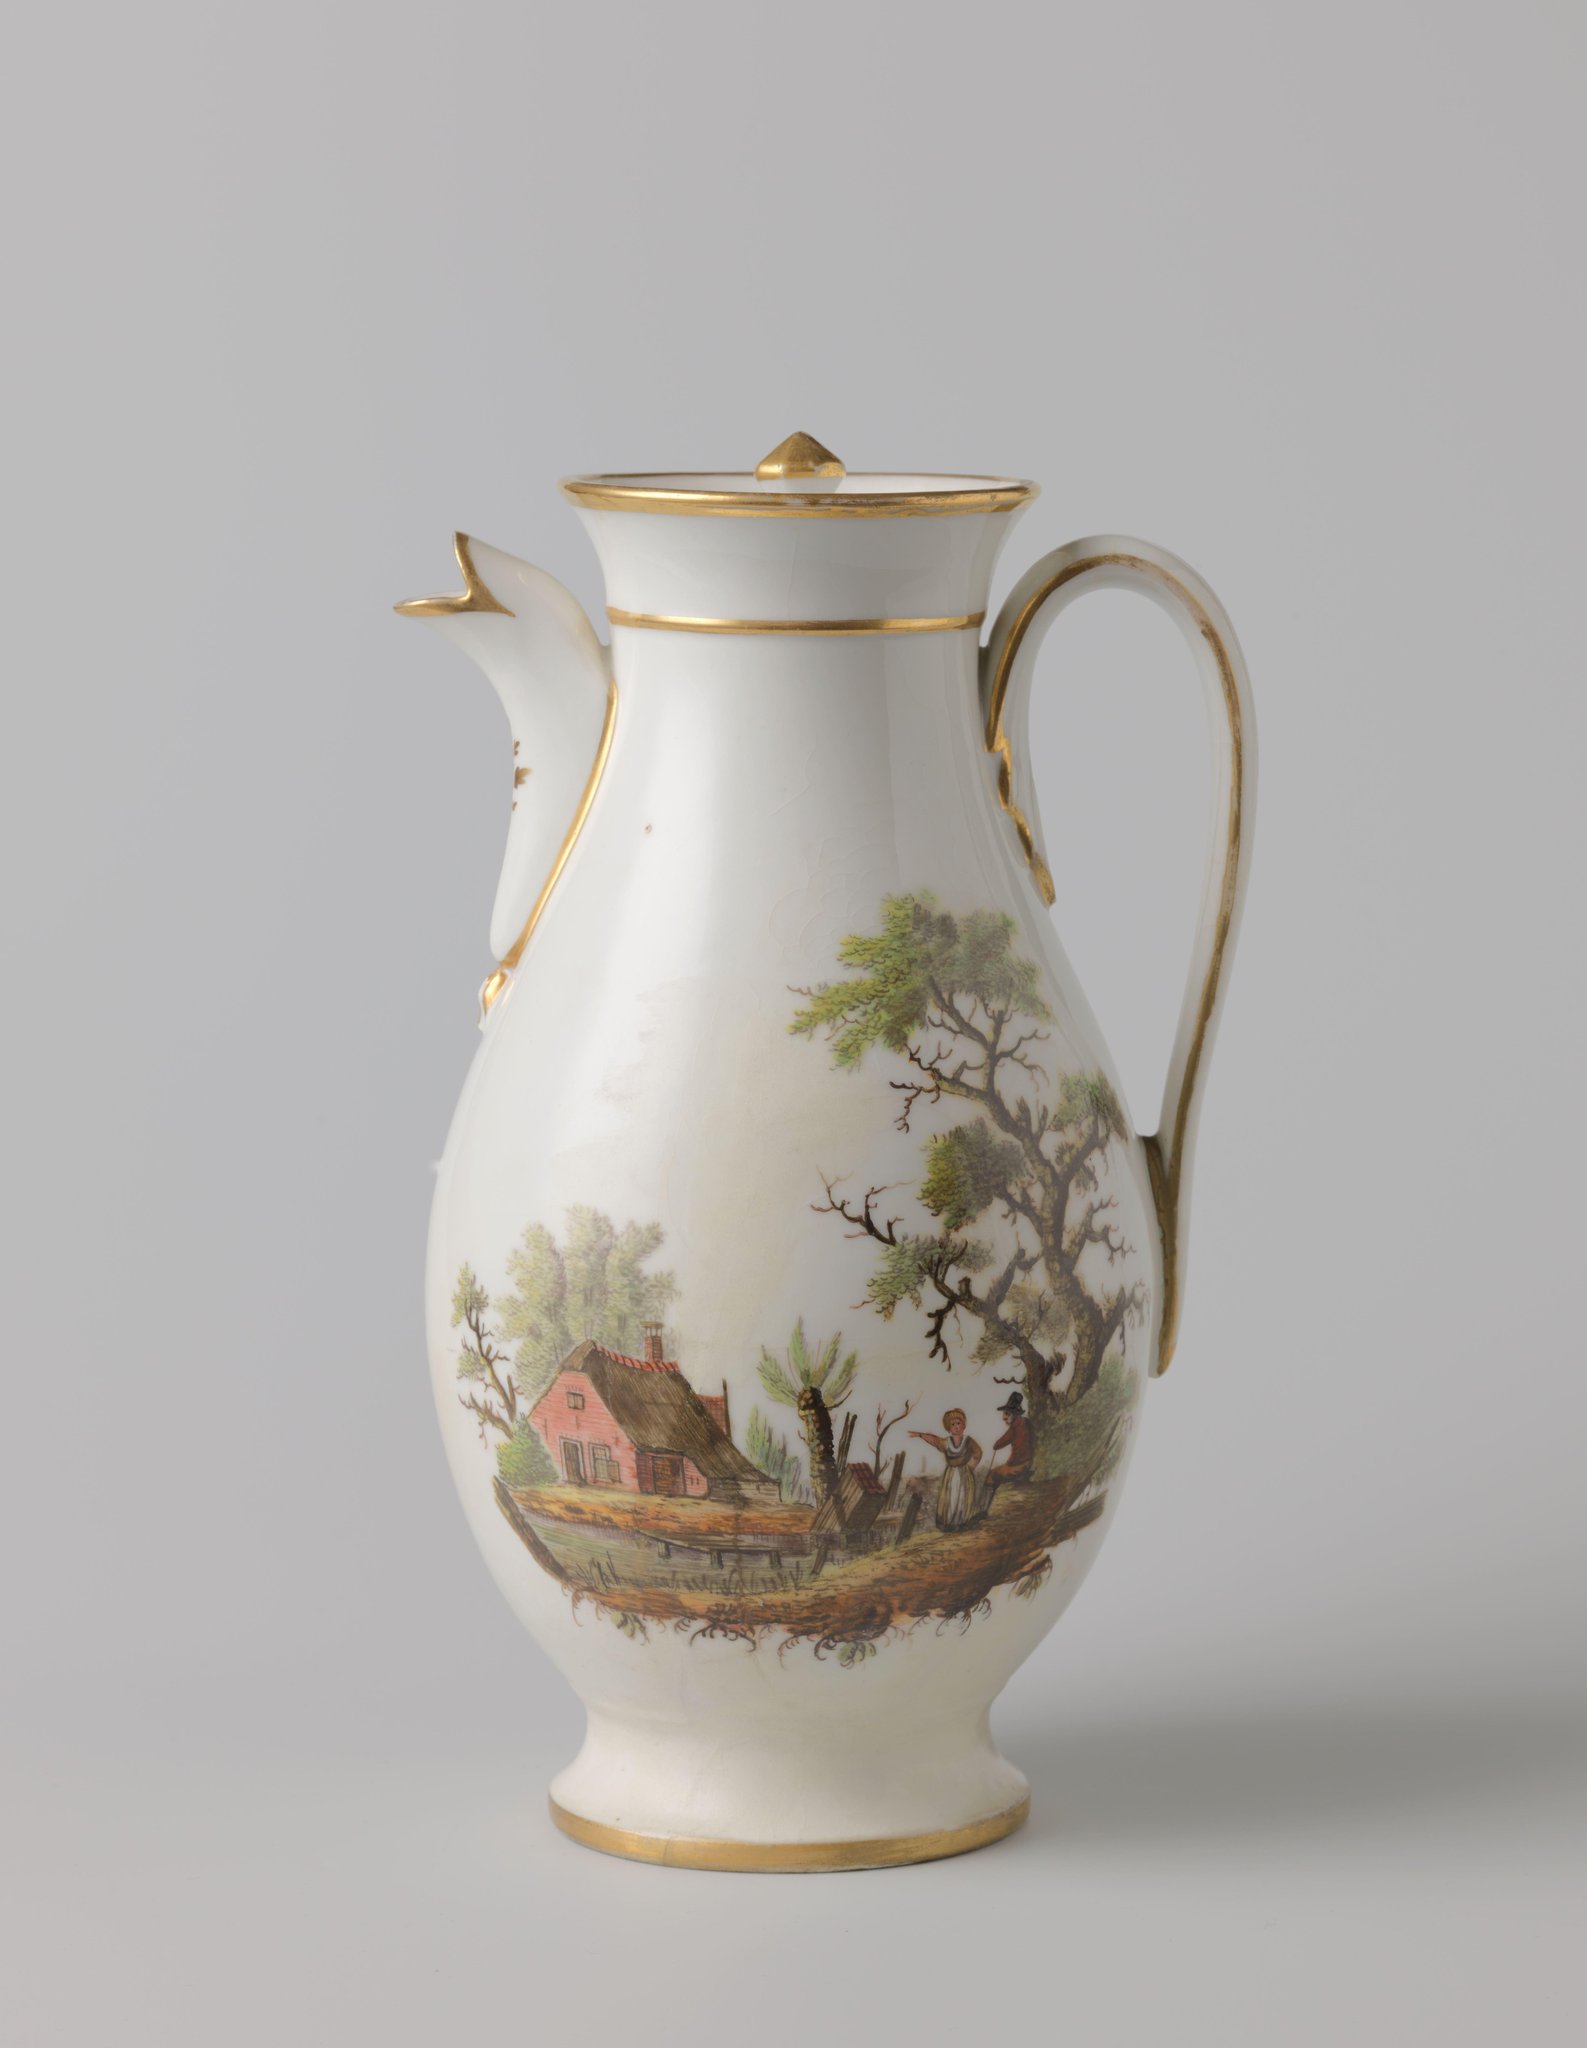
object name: coffee pot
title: Koffiekan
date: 1809-1814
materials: porcelain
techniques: painted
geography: nieuwer-amstel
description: Koffiekan, peervormig en veelkleurig beschilderd met figuren in een landschap. Man en vrouw en bowerderij langs de rivier. Goudkleurige randen. Gemerkt: Amstel in bruin boven het glazuur.